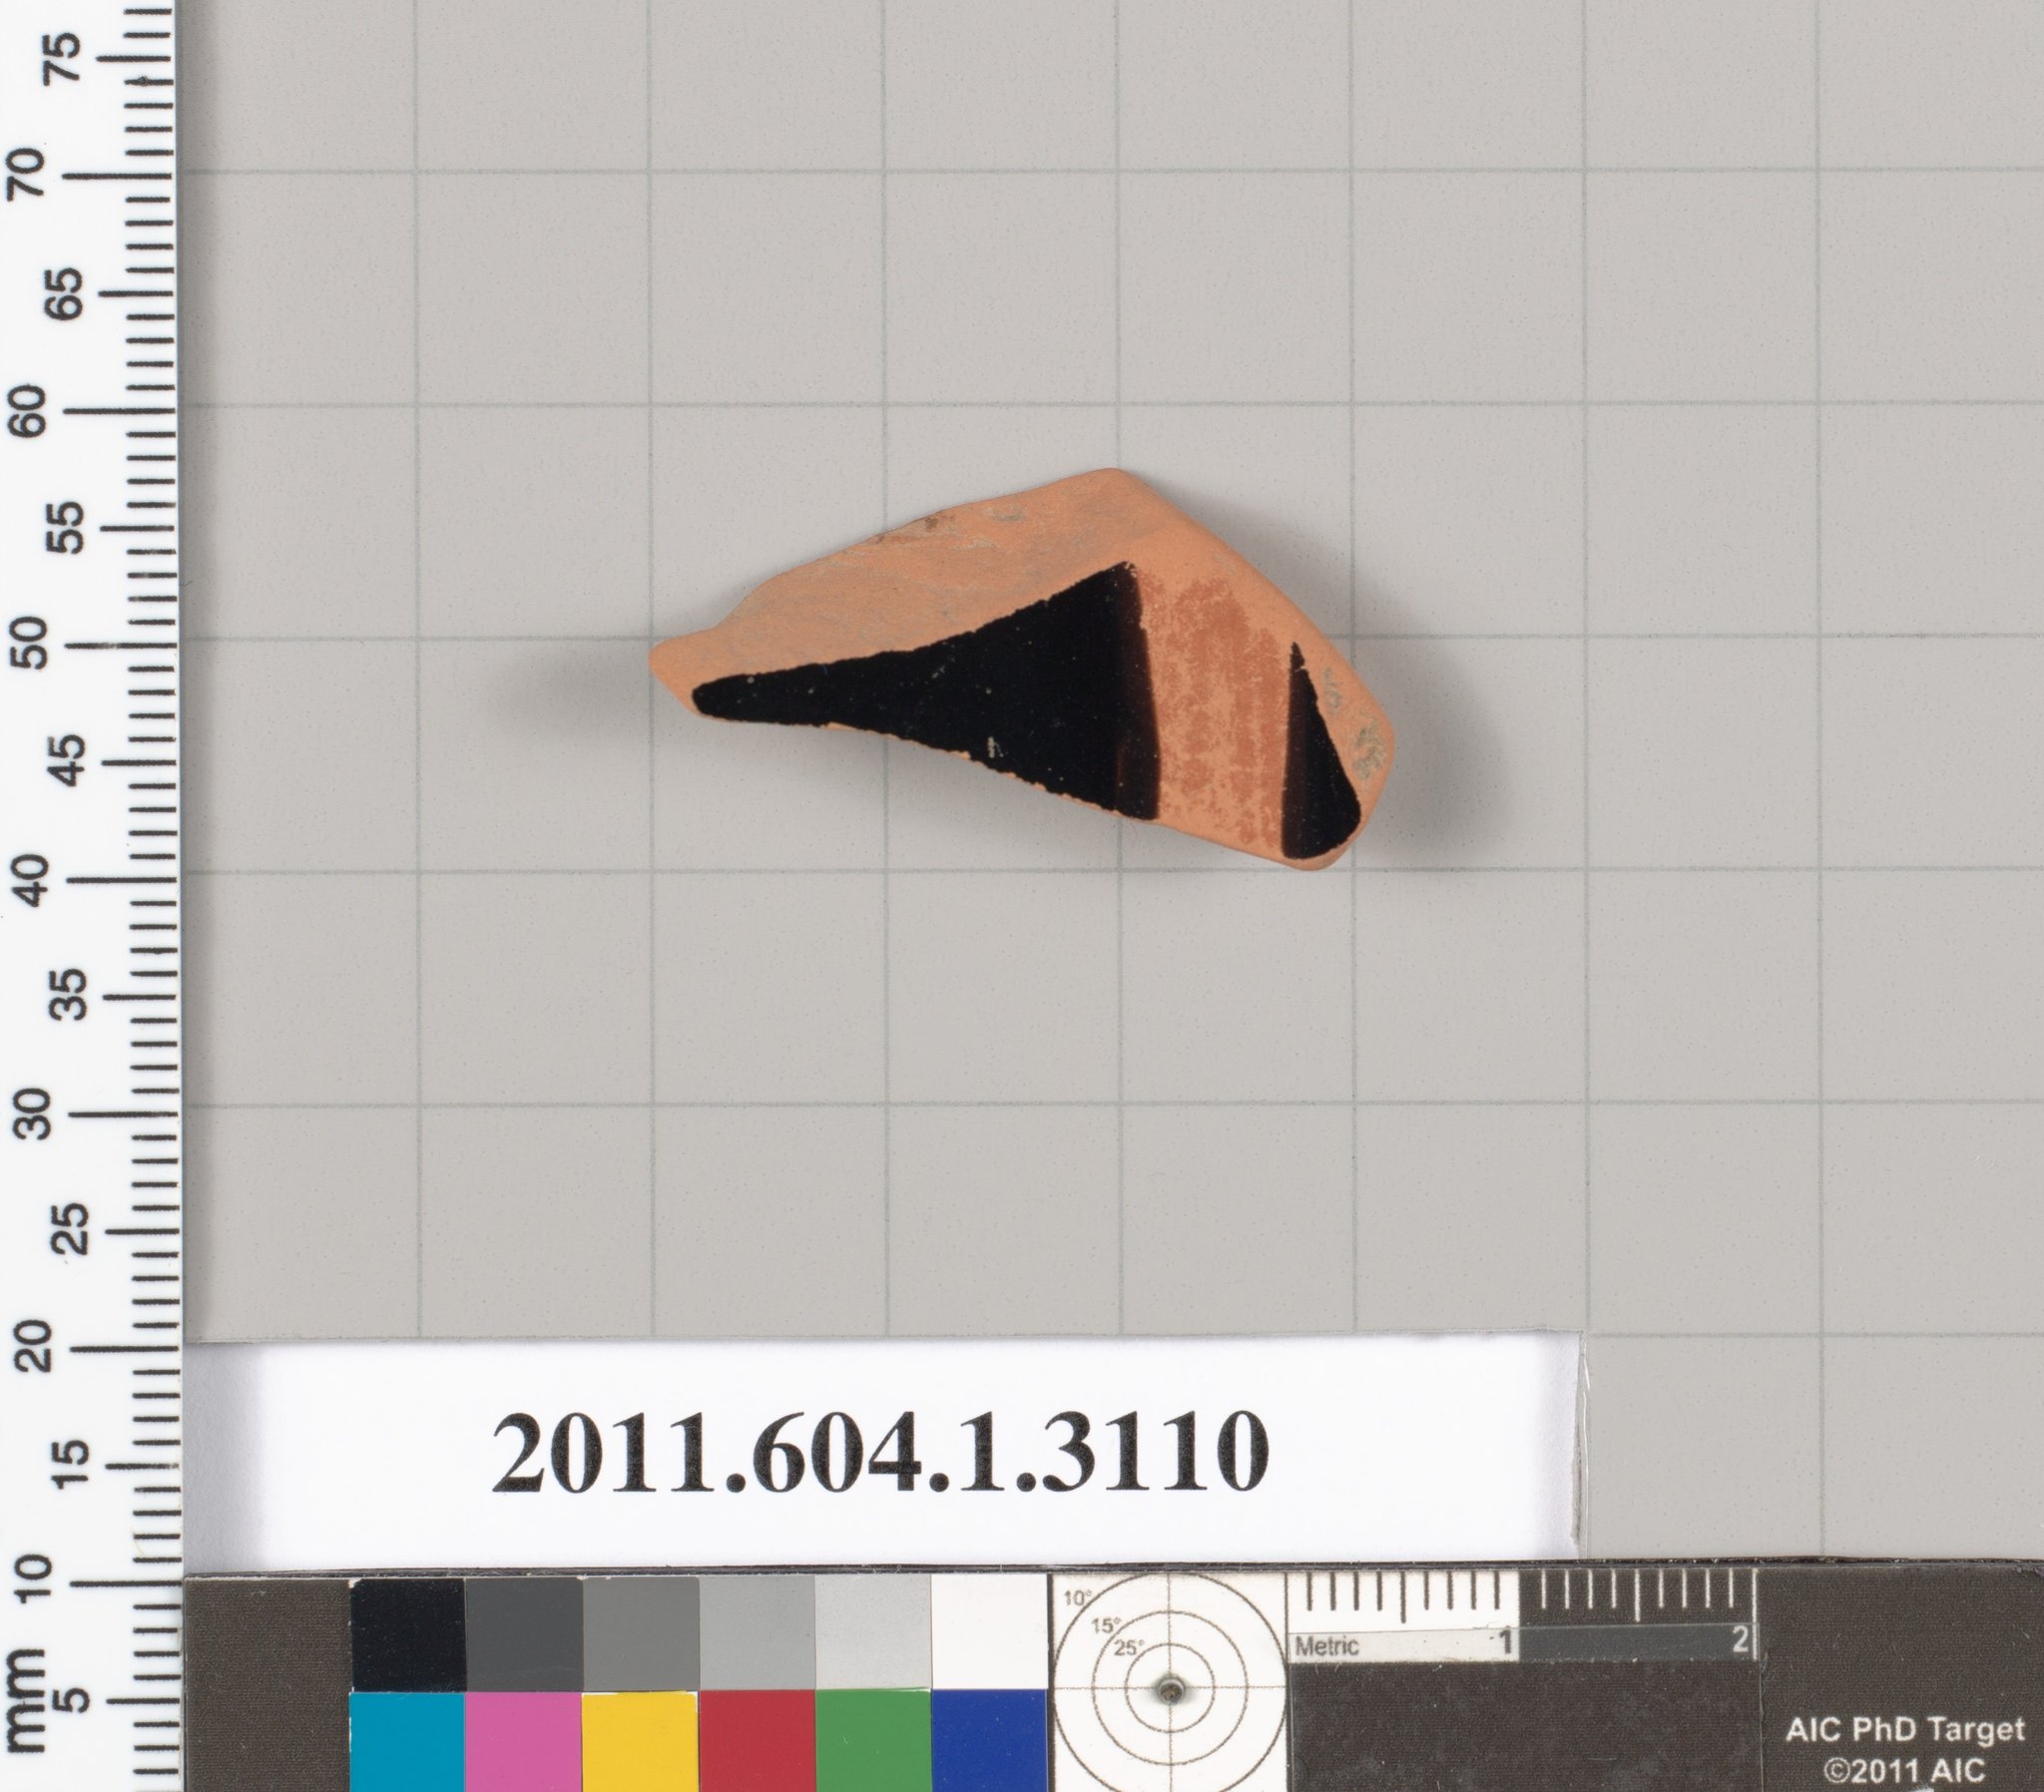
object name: kylix fragment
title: Terracotta fragment of a kylix (drinking cup)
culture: greek, attic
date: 500-451 BCE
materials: terracotta